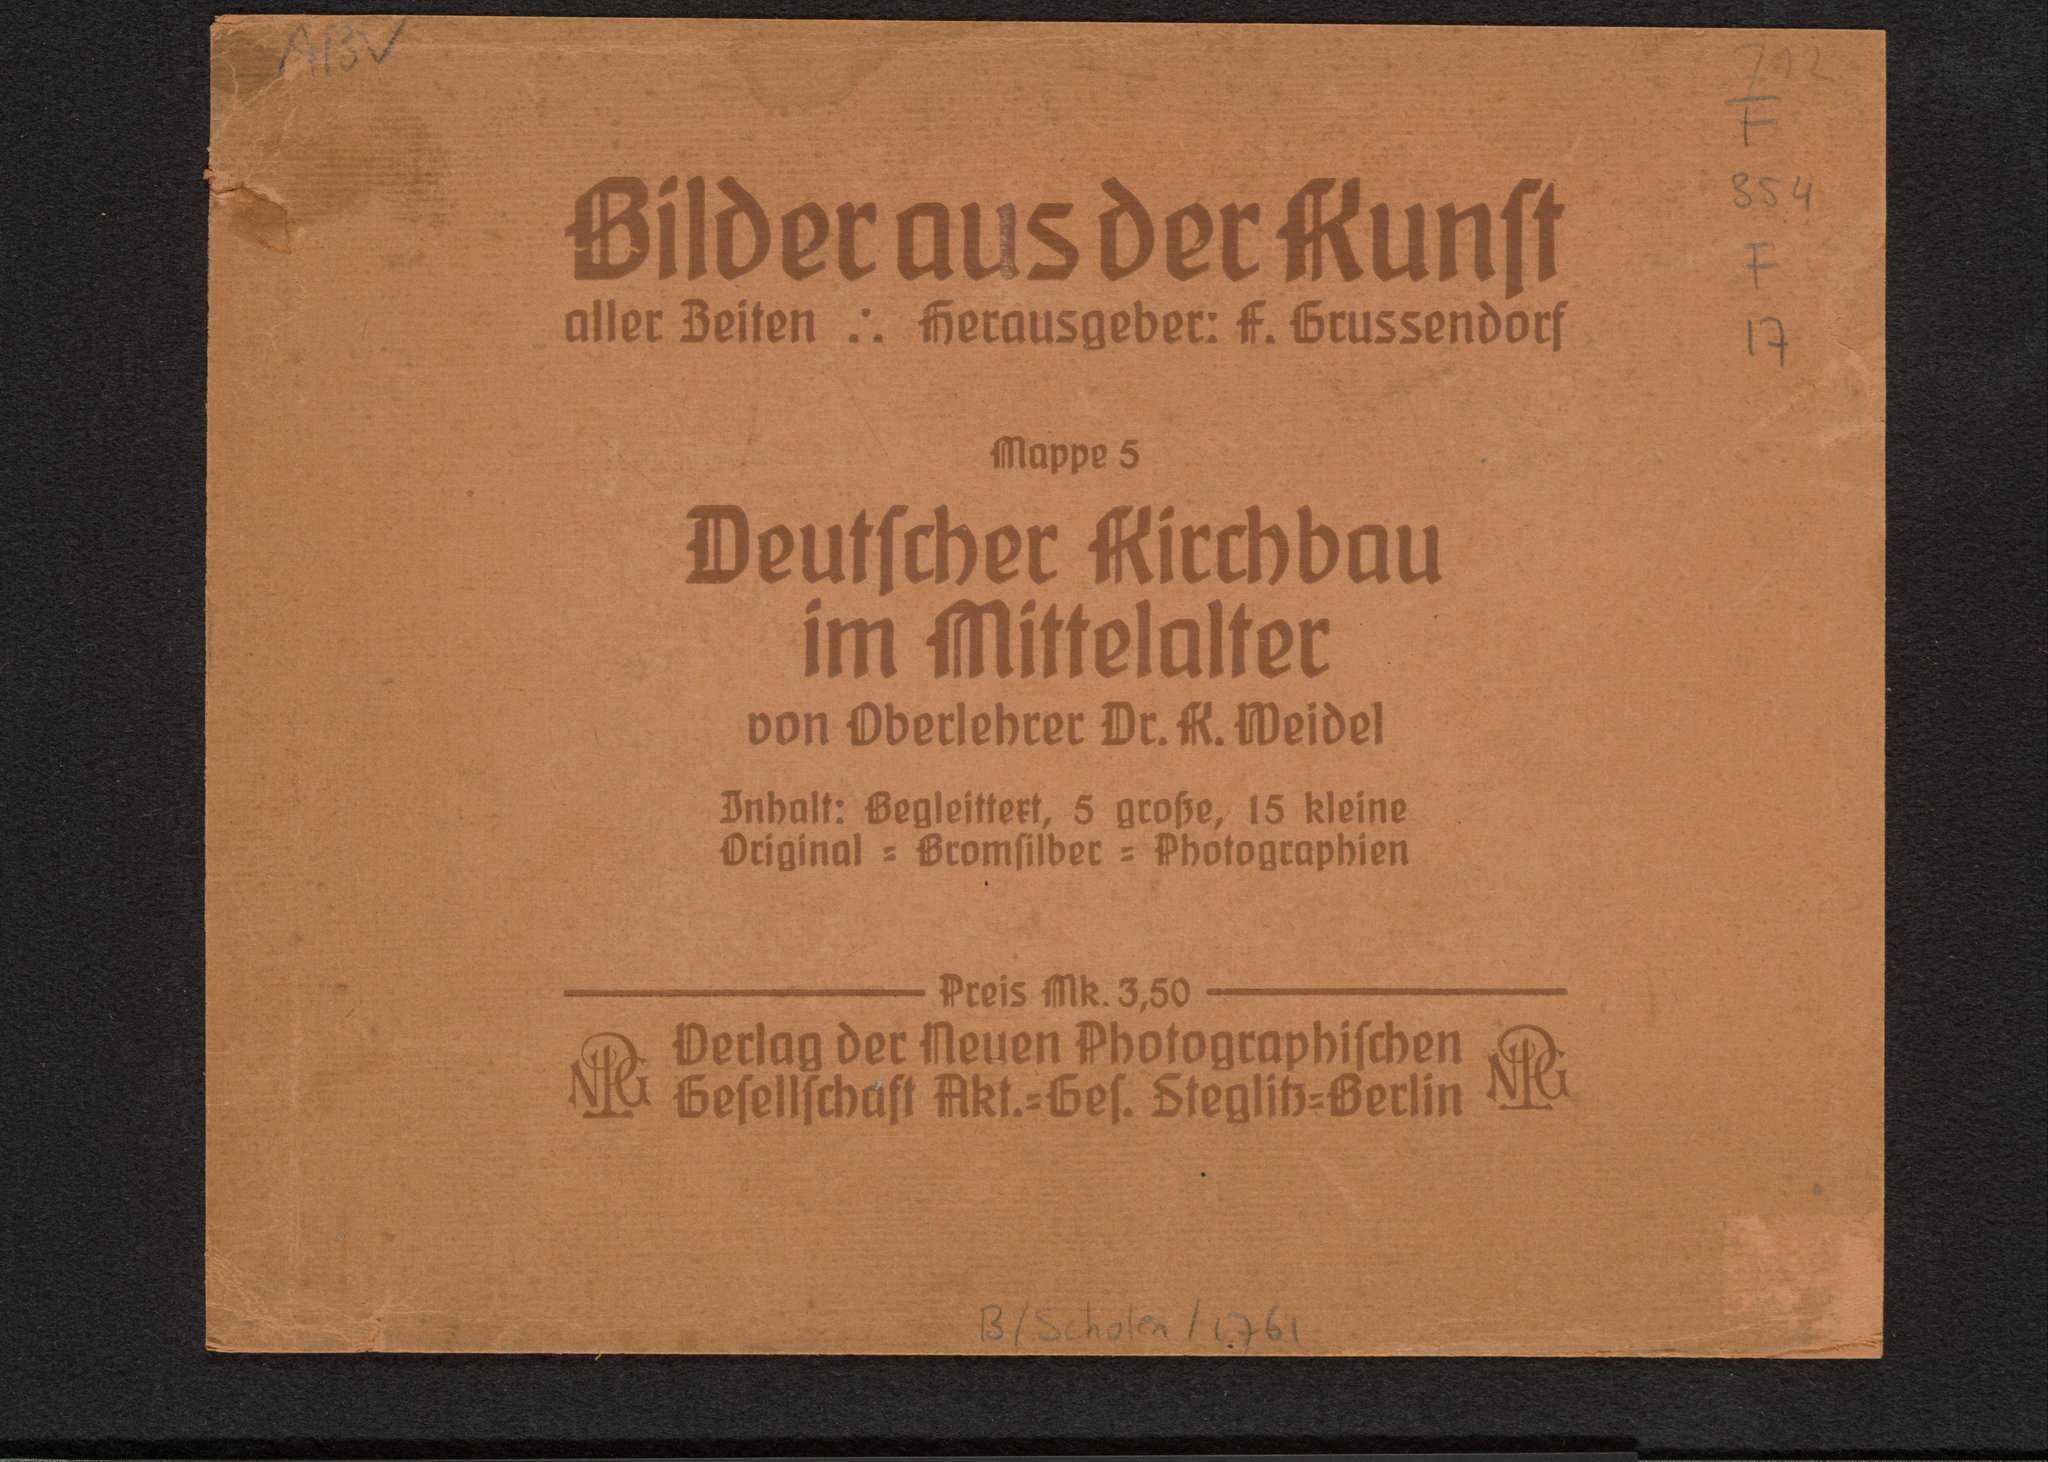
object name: portfolio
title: Deutscher Kirchenbau im Mittelalter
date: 1911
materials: cardboard, paper, photographic support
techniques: gelatin silver print